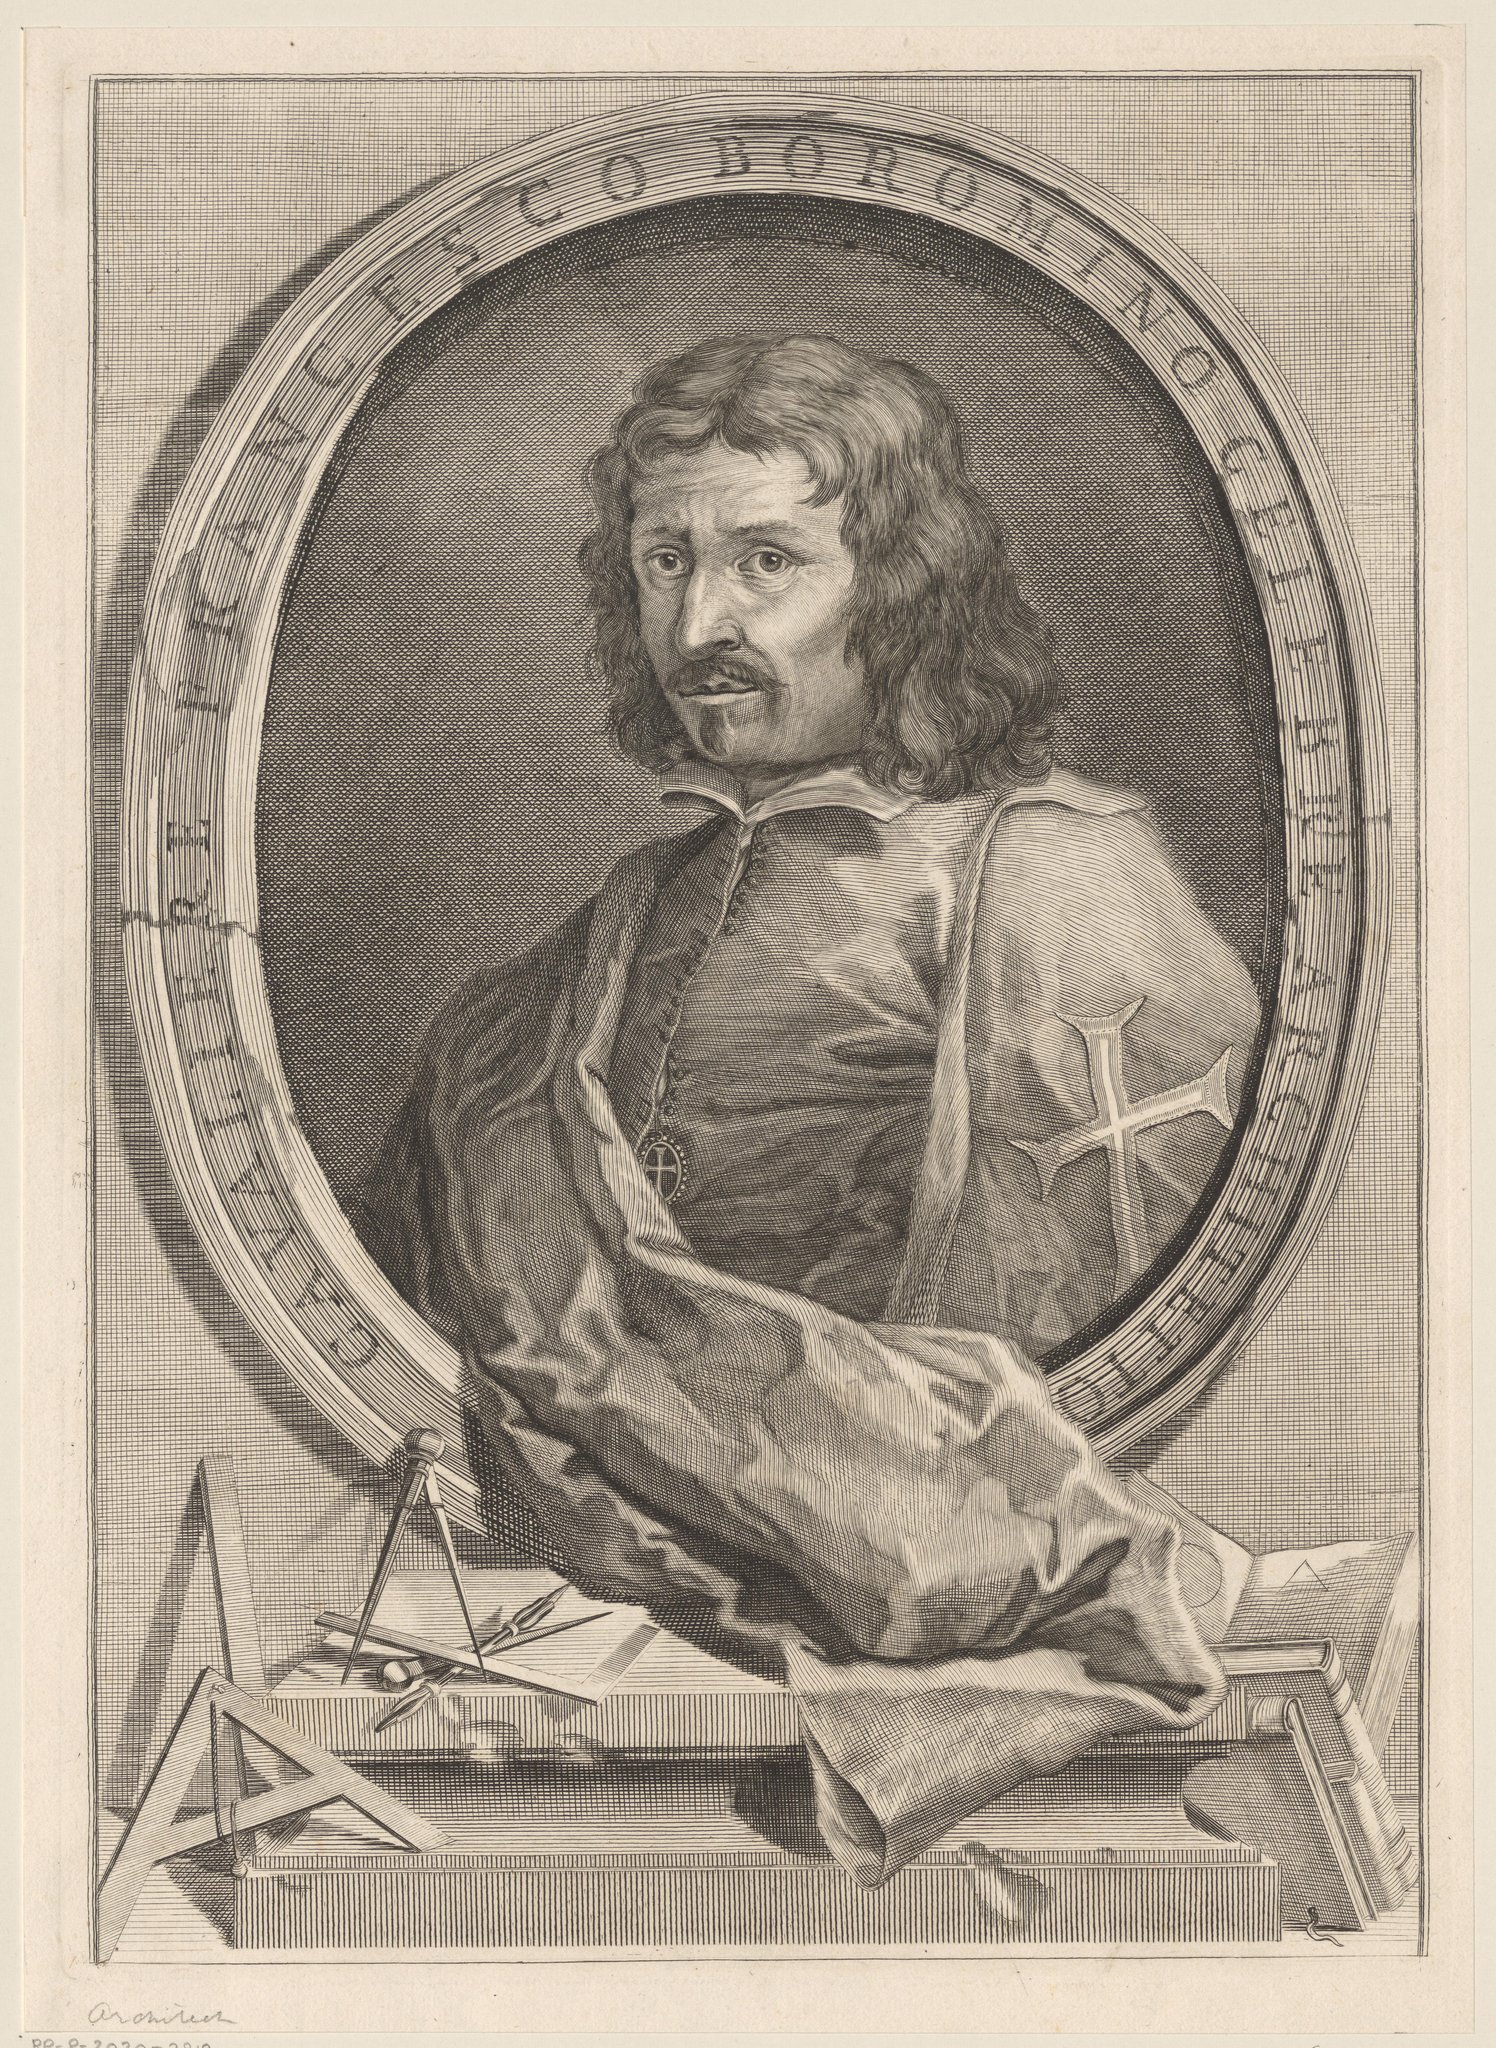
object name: print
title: Portret van Francesco Borromini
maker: Anonymous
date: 1650-1699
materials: paper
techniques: engraving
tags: rome, draughtsman, francesco borromini, historical persons, measuring-instruments, portrait, self-portrait of architect